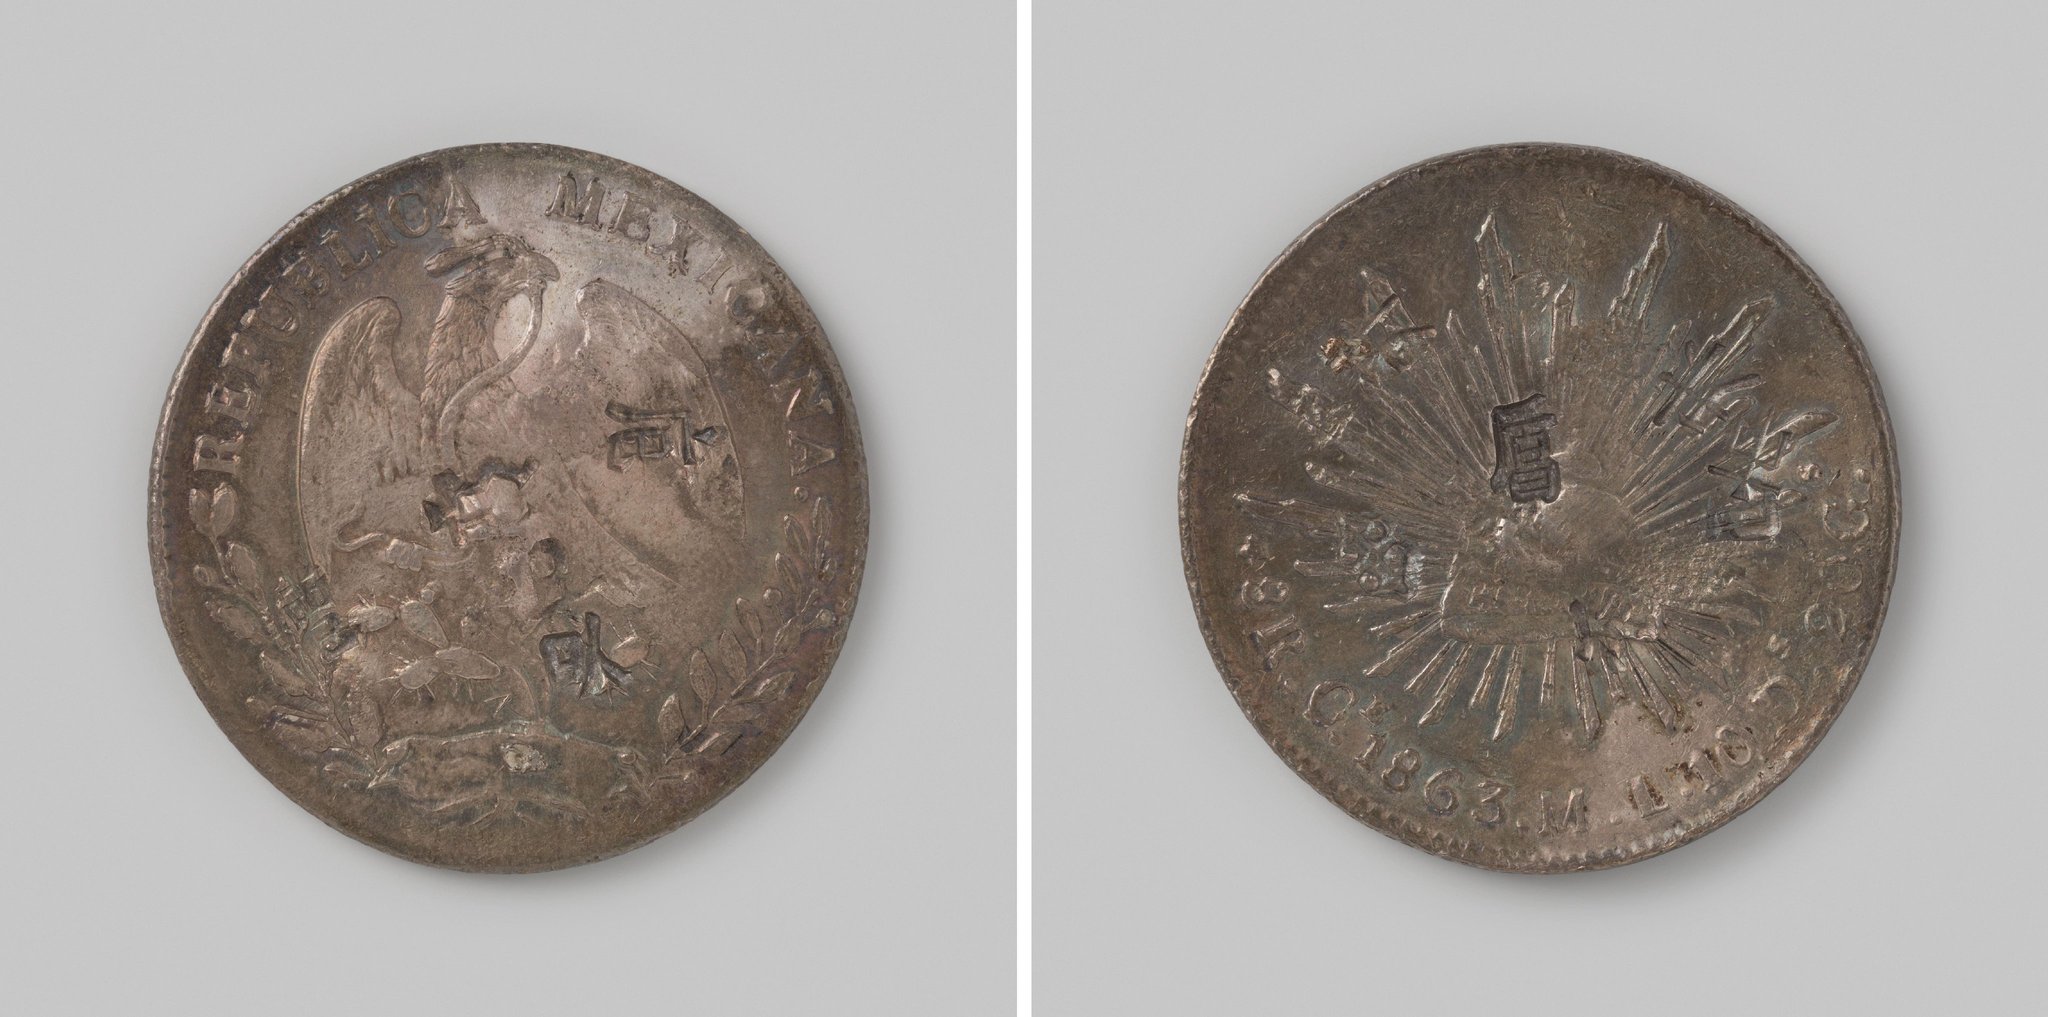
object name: peso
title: Peso of acht reaal uit de republiek Mexico, 1863, geslagen te Real de Catorce, waarbij in China op de voorzijde vijf - en op de keerzijde zes sinogrammen zijn ingestempeld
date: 1863-1900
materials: silver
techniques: striking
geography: real de catorce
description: Zilveren munt. Voorzijde: op takken staande adelaar omkijkend naar rechts. Keerzijde: door stralen omgeven vrijheidshoed. In omschrift onderaan waarde-aanduiding: 8 R en jaartal. Geribde rand. Op voorzijde zijn vijf en op de keerzijde zes sinogrammen met vermelding van de naam van een Chinees handelshuis, tot waarborg van de echtheid, ingestempeld.